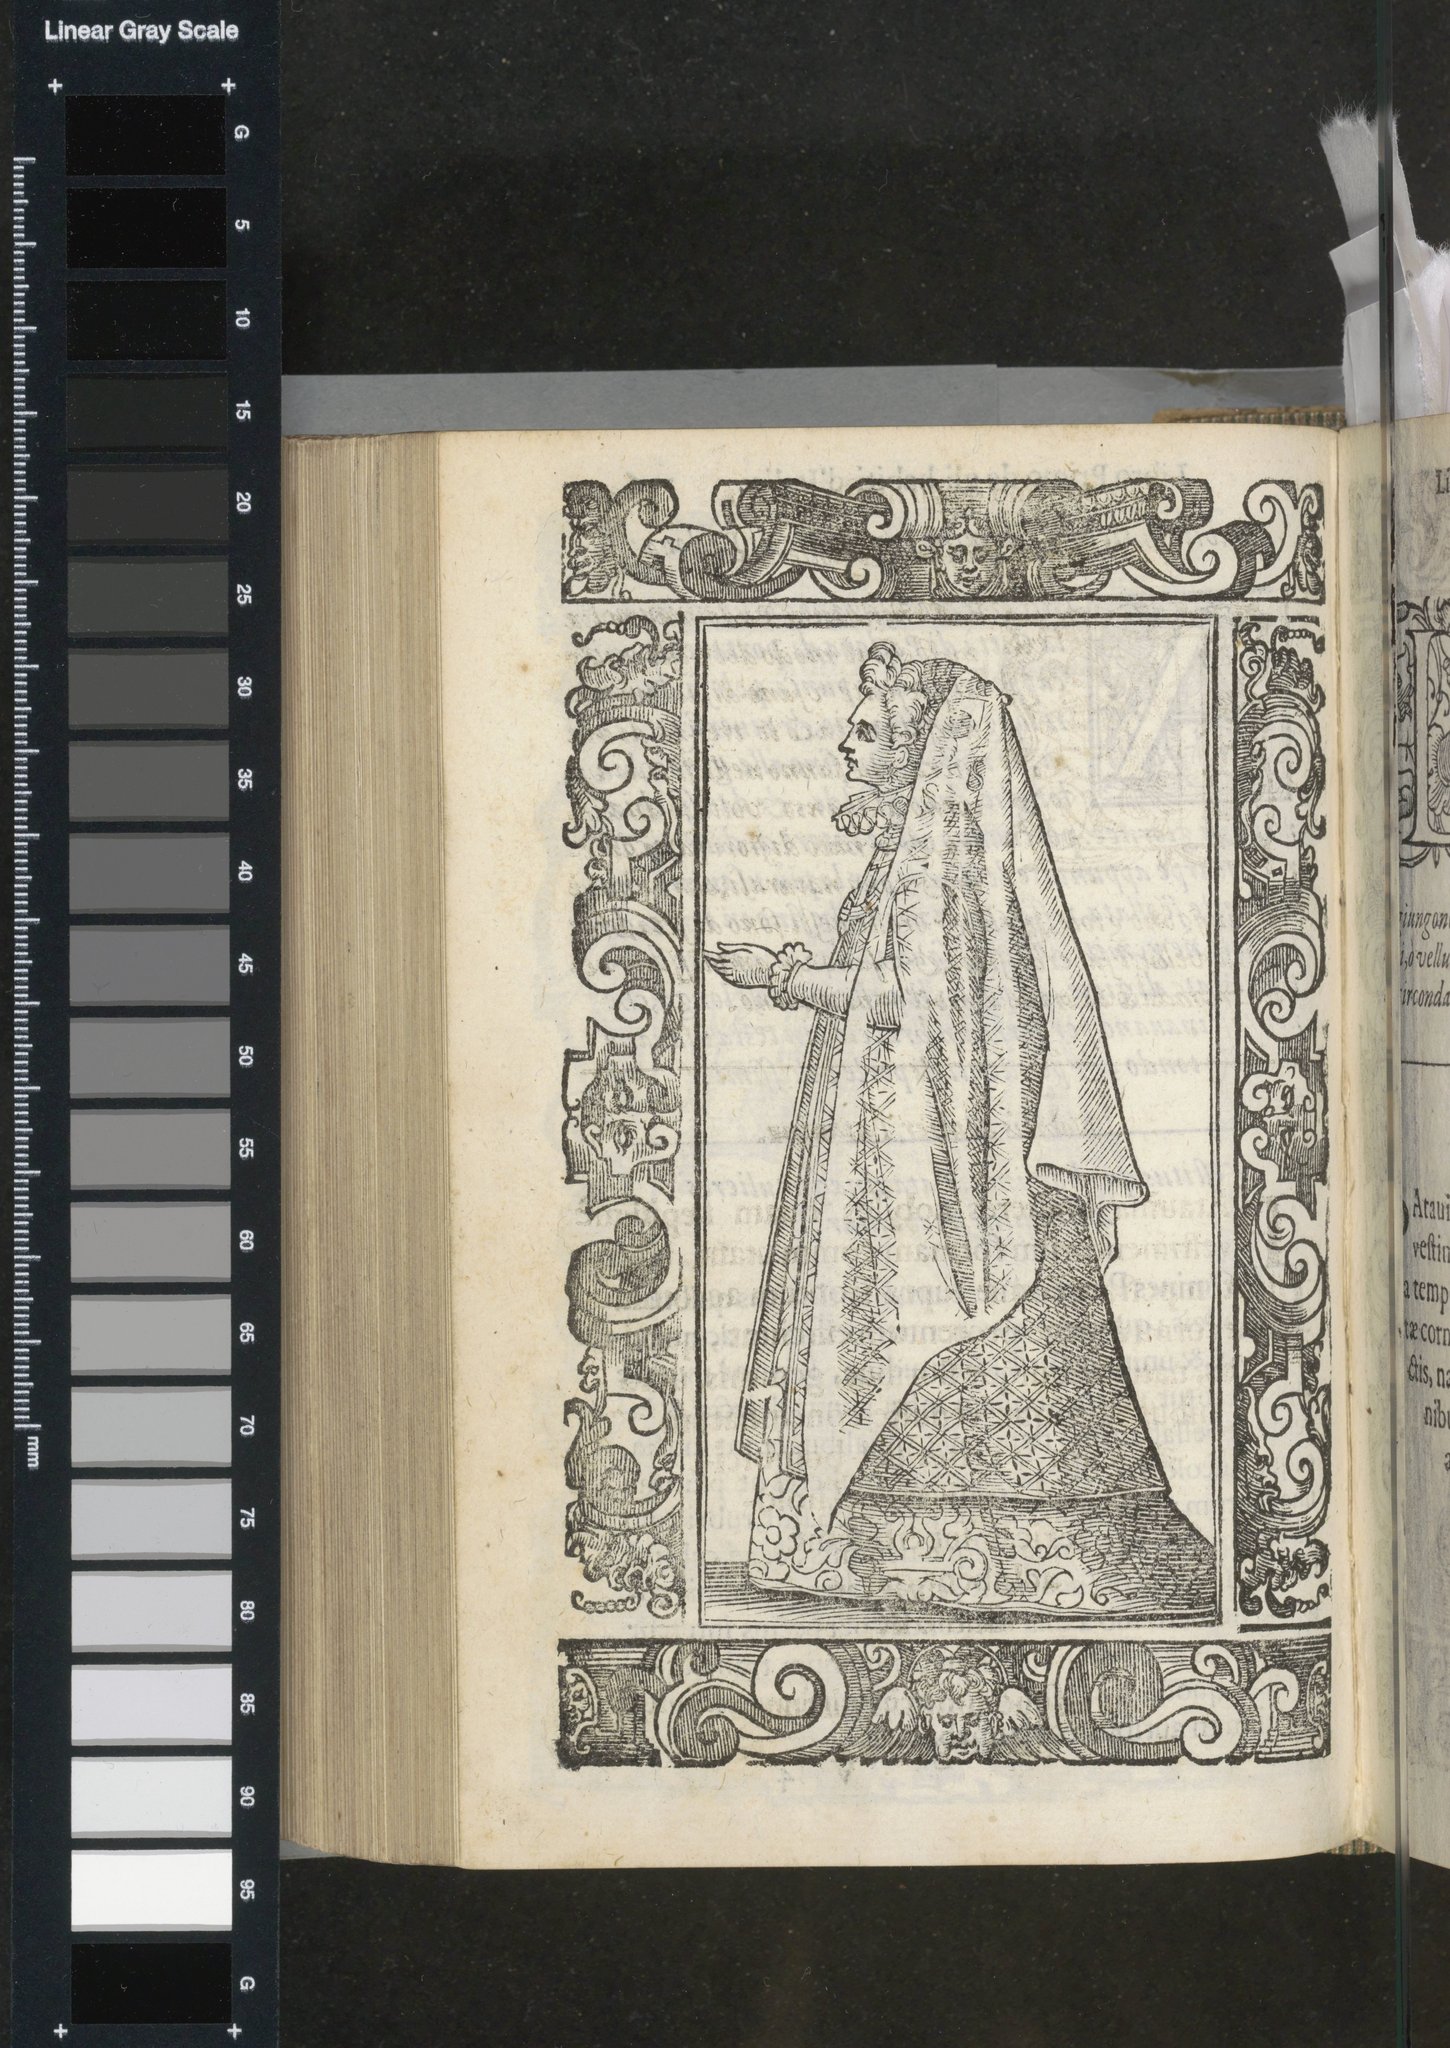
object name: costume print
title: Nobile padovana moderna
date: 1598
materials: paper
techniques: woodcut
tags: fashion plates